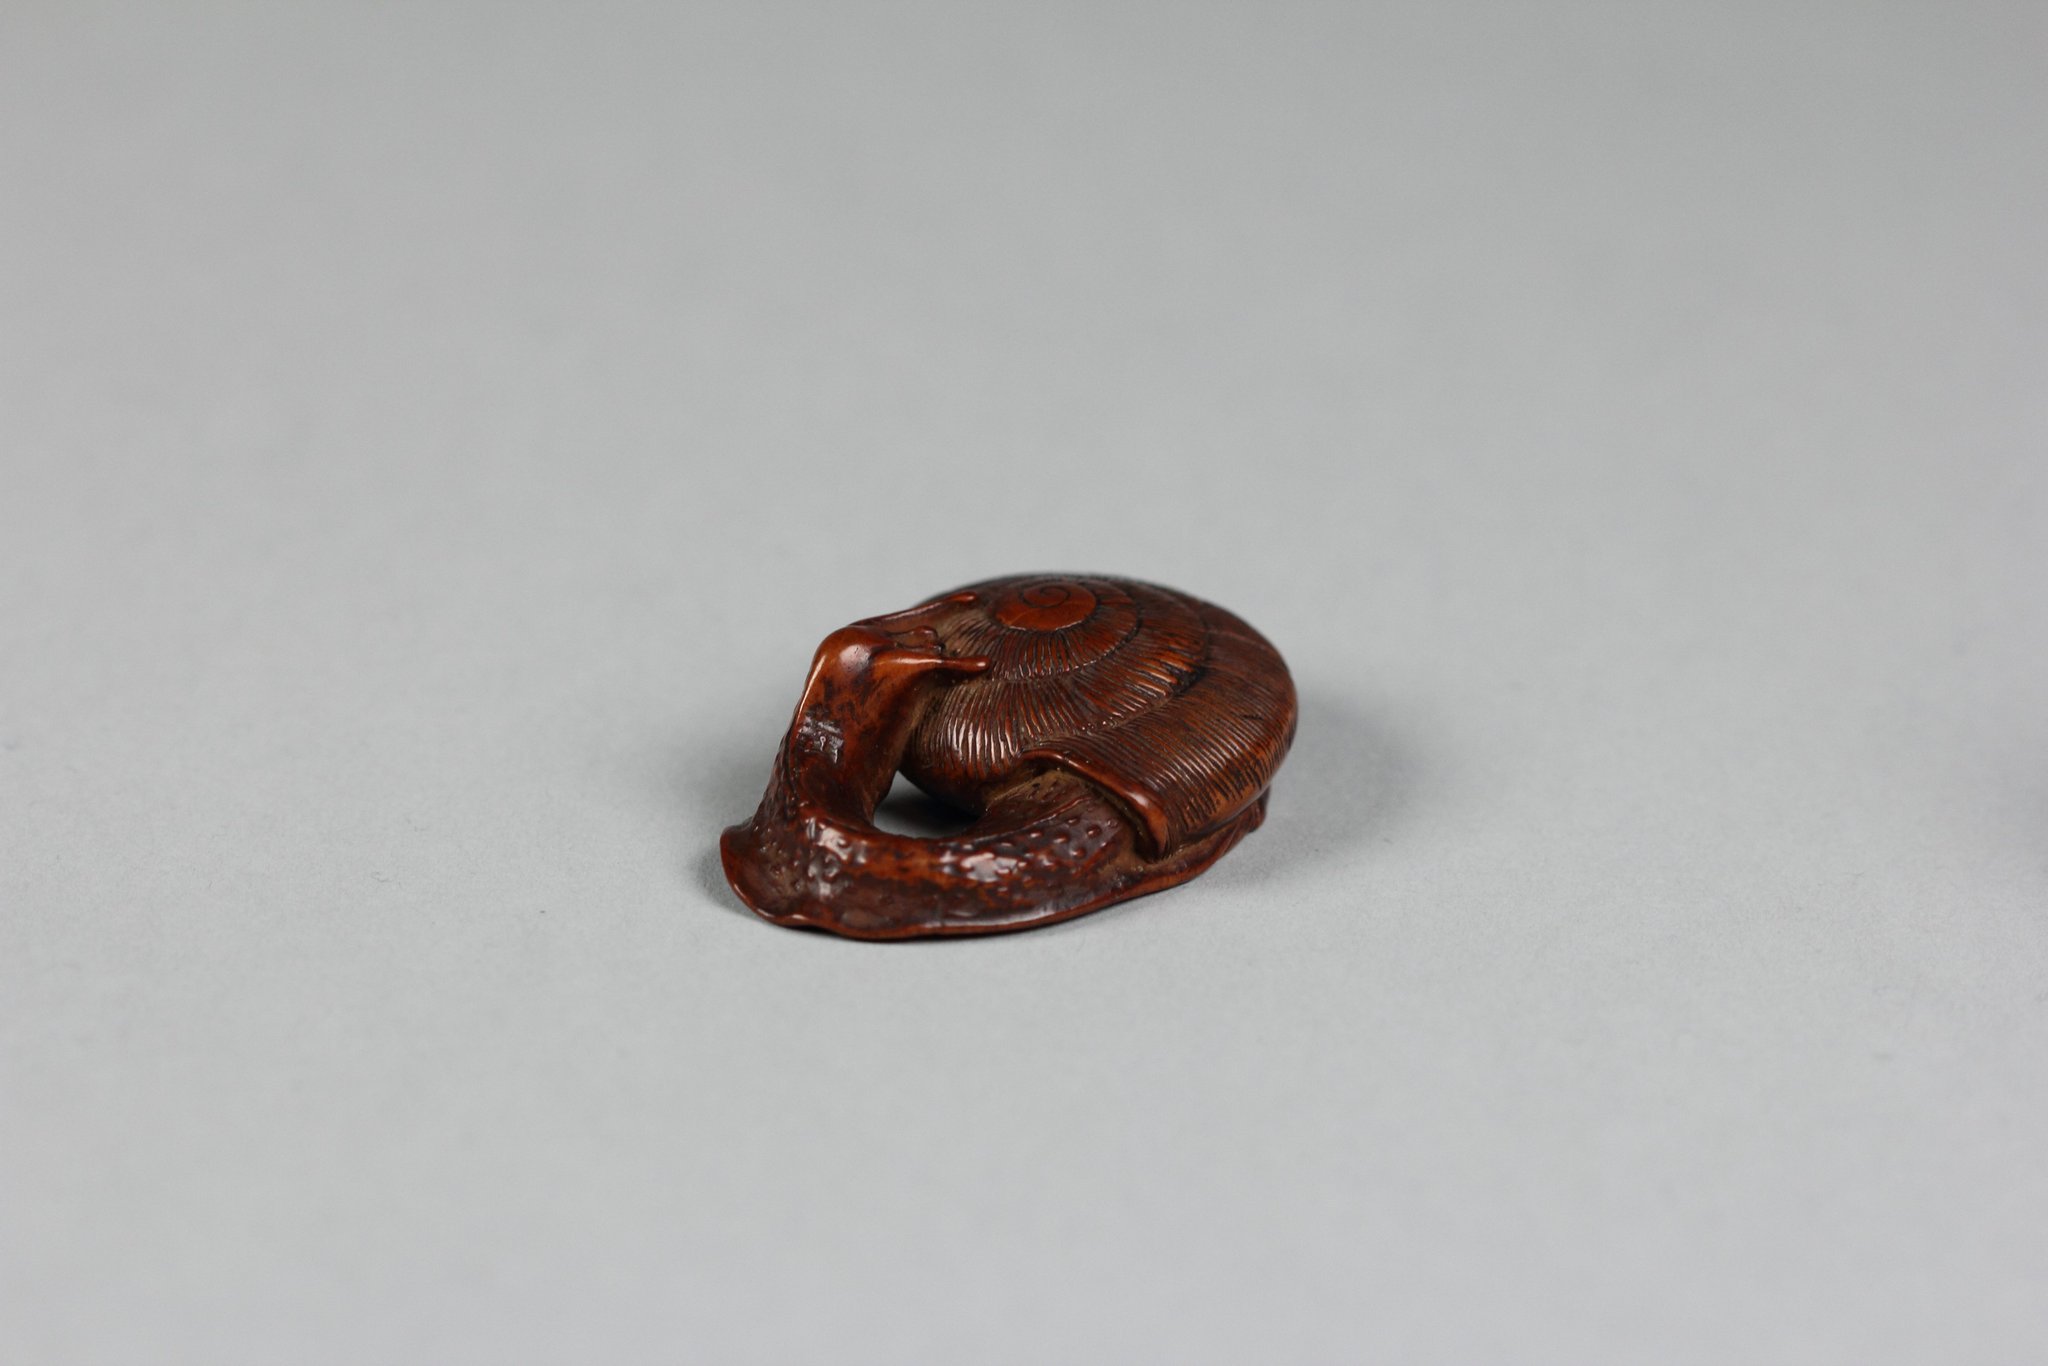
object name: netsuke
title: Netsuke of Snail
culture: japanese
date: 1801-1900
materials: wood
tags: snails